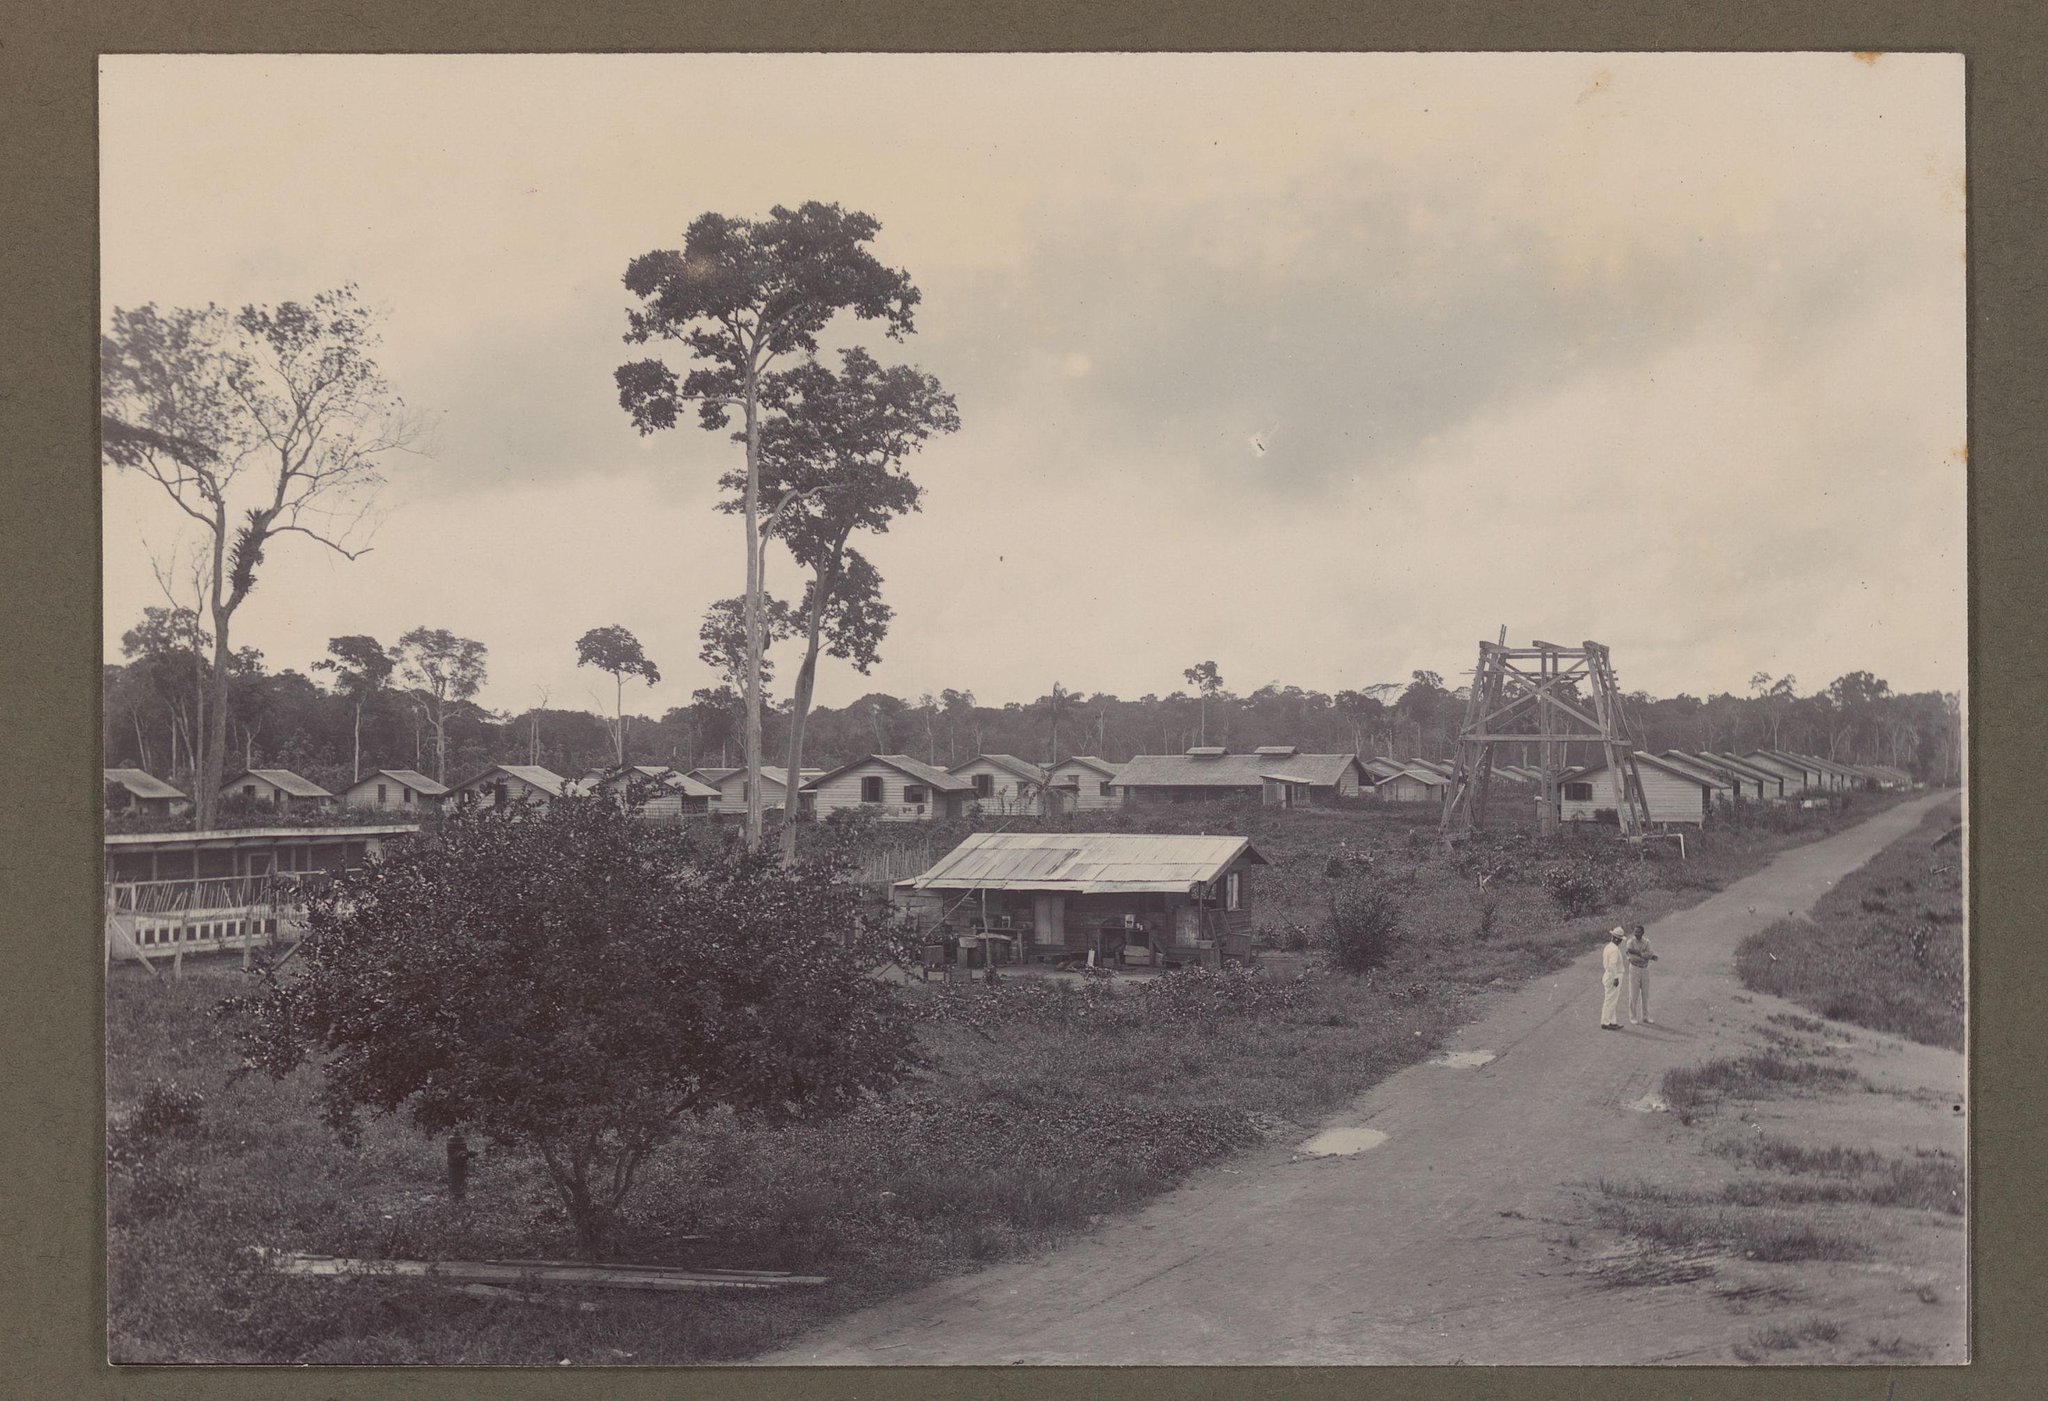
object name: photograph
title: Terrein met woningen te Moengo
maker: Anonymous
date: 1925-1927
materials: photographic support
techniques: photography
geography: suriname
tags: jetten, familie, moengo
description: Terrein met woningen te Moengo. Foto op een bladzijde van een los albumblad. Onderdeel van het ensemble met foto's van de familie van ingenieur Jetten in de mijnbouwstad Moengo in Suriname.